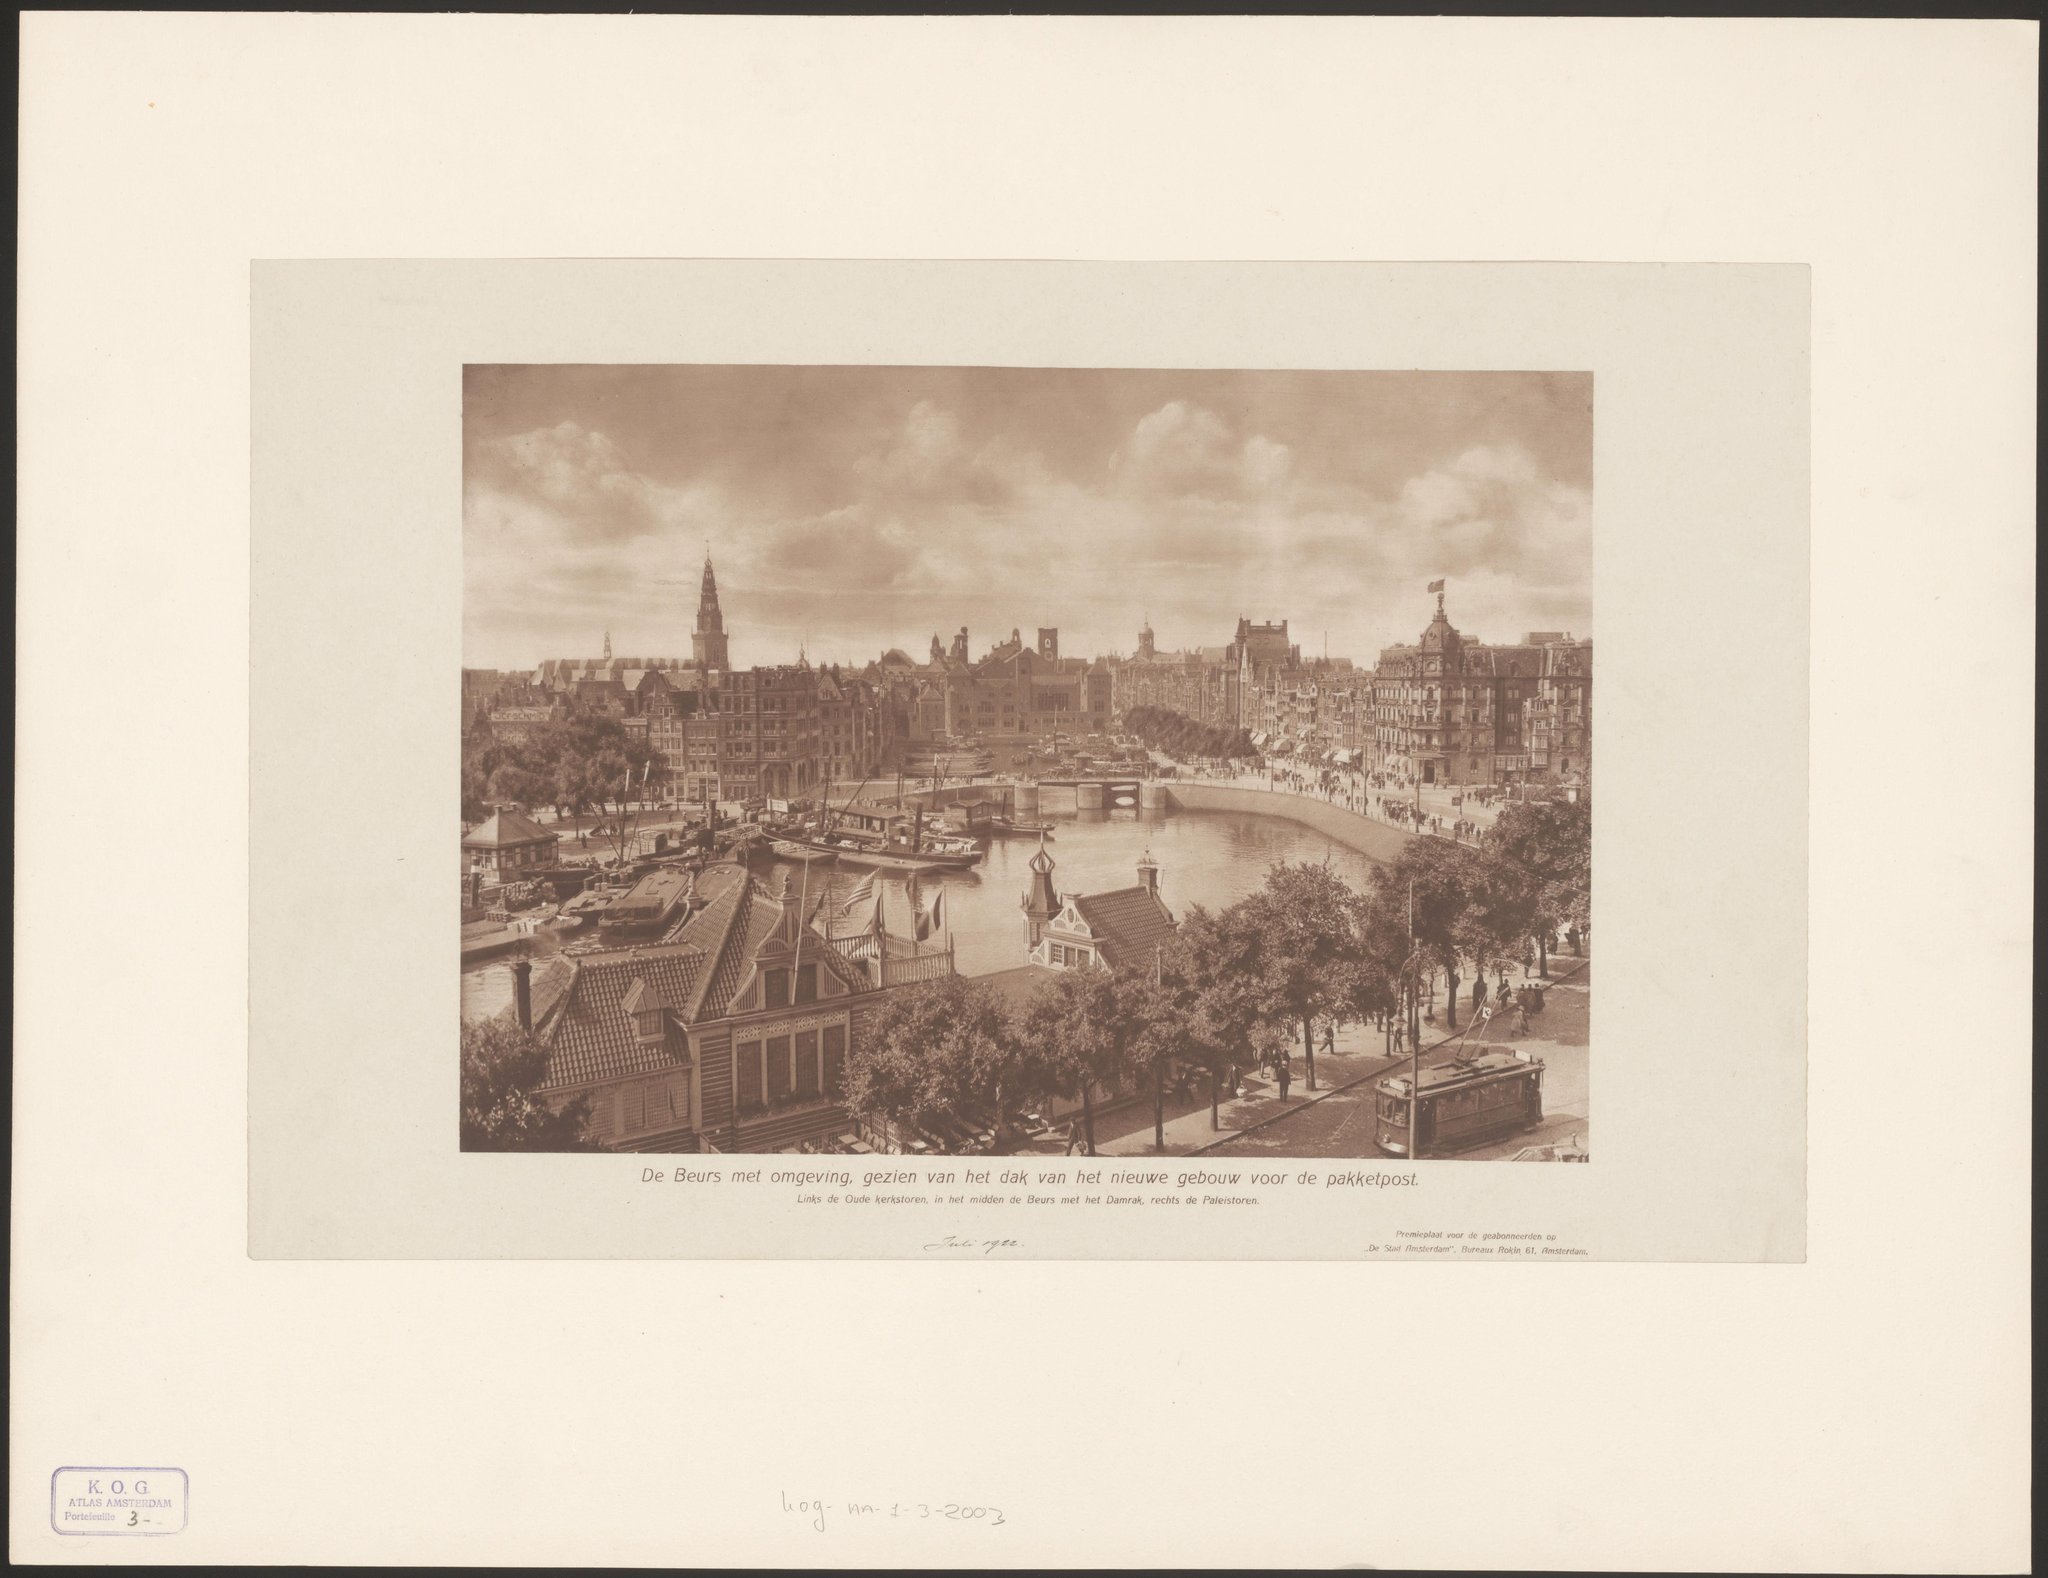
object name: photomechanical print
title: Gezicht op het Damrak en de Beurs van Berlage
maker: Anonymous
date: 1907-1922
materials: cardboard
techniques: rotogravure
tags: tramway, tram, city-view in general; 'veduta', river, bridge in city across river, canal, etc., market-hall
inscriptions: date: ‘Juli 1922.’, collector's mark: ‘3-’ Lugt 1641b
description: Onderwerpsrubriek binnen de Atlas Amsterdam: Panorama's en verzamelprenten.